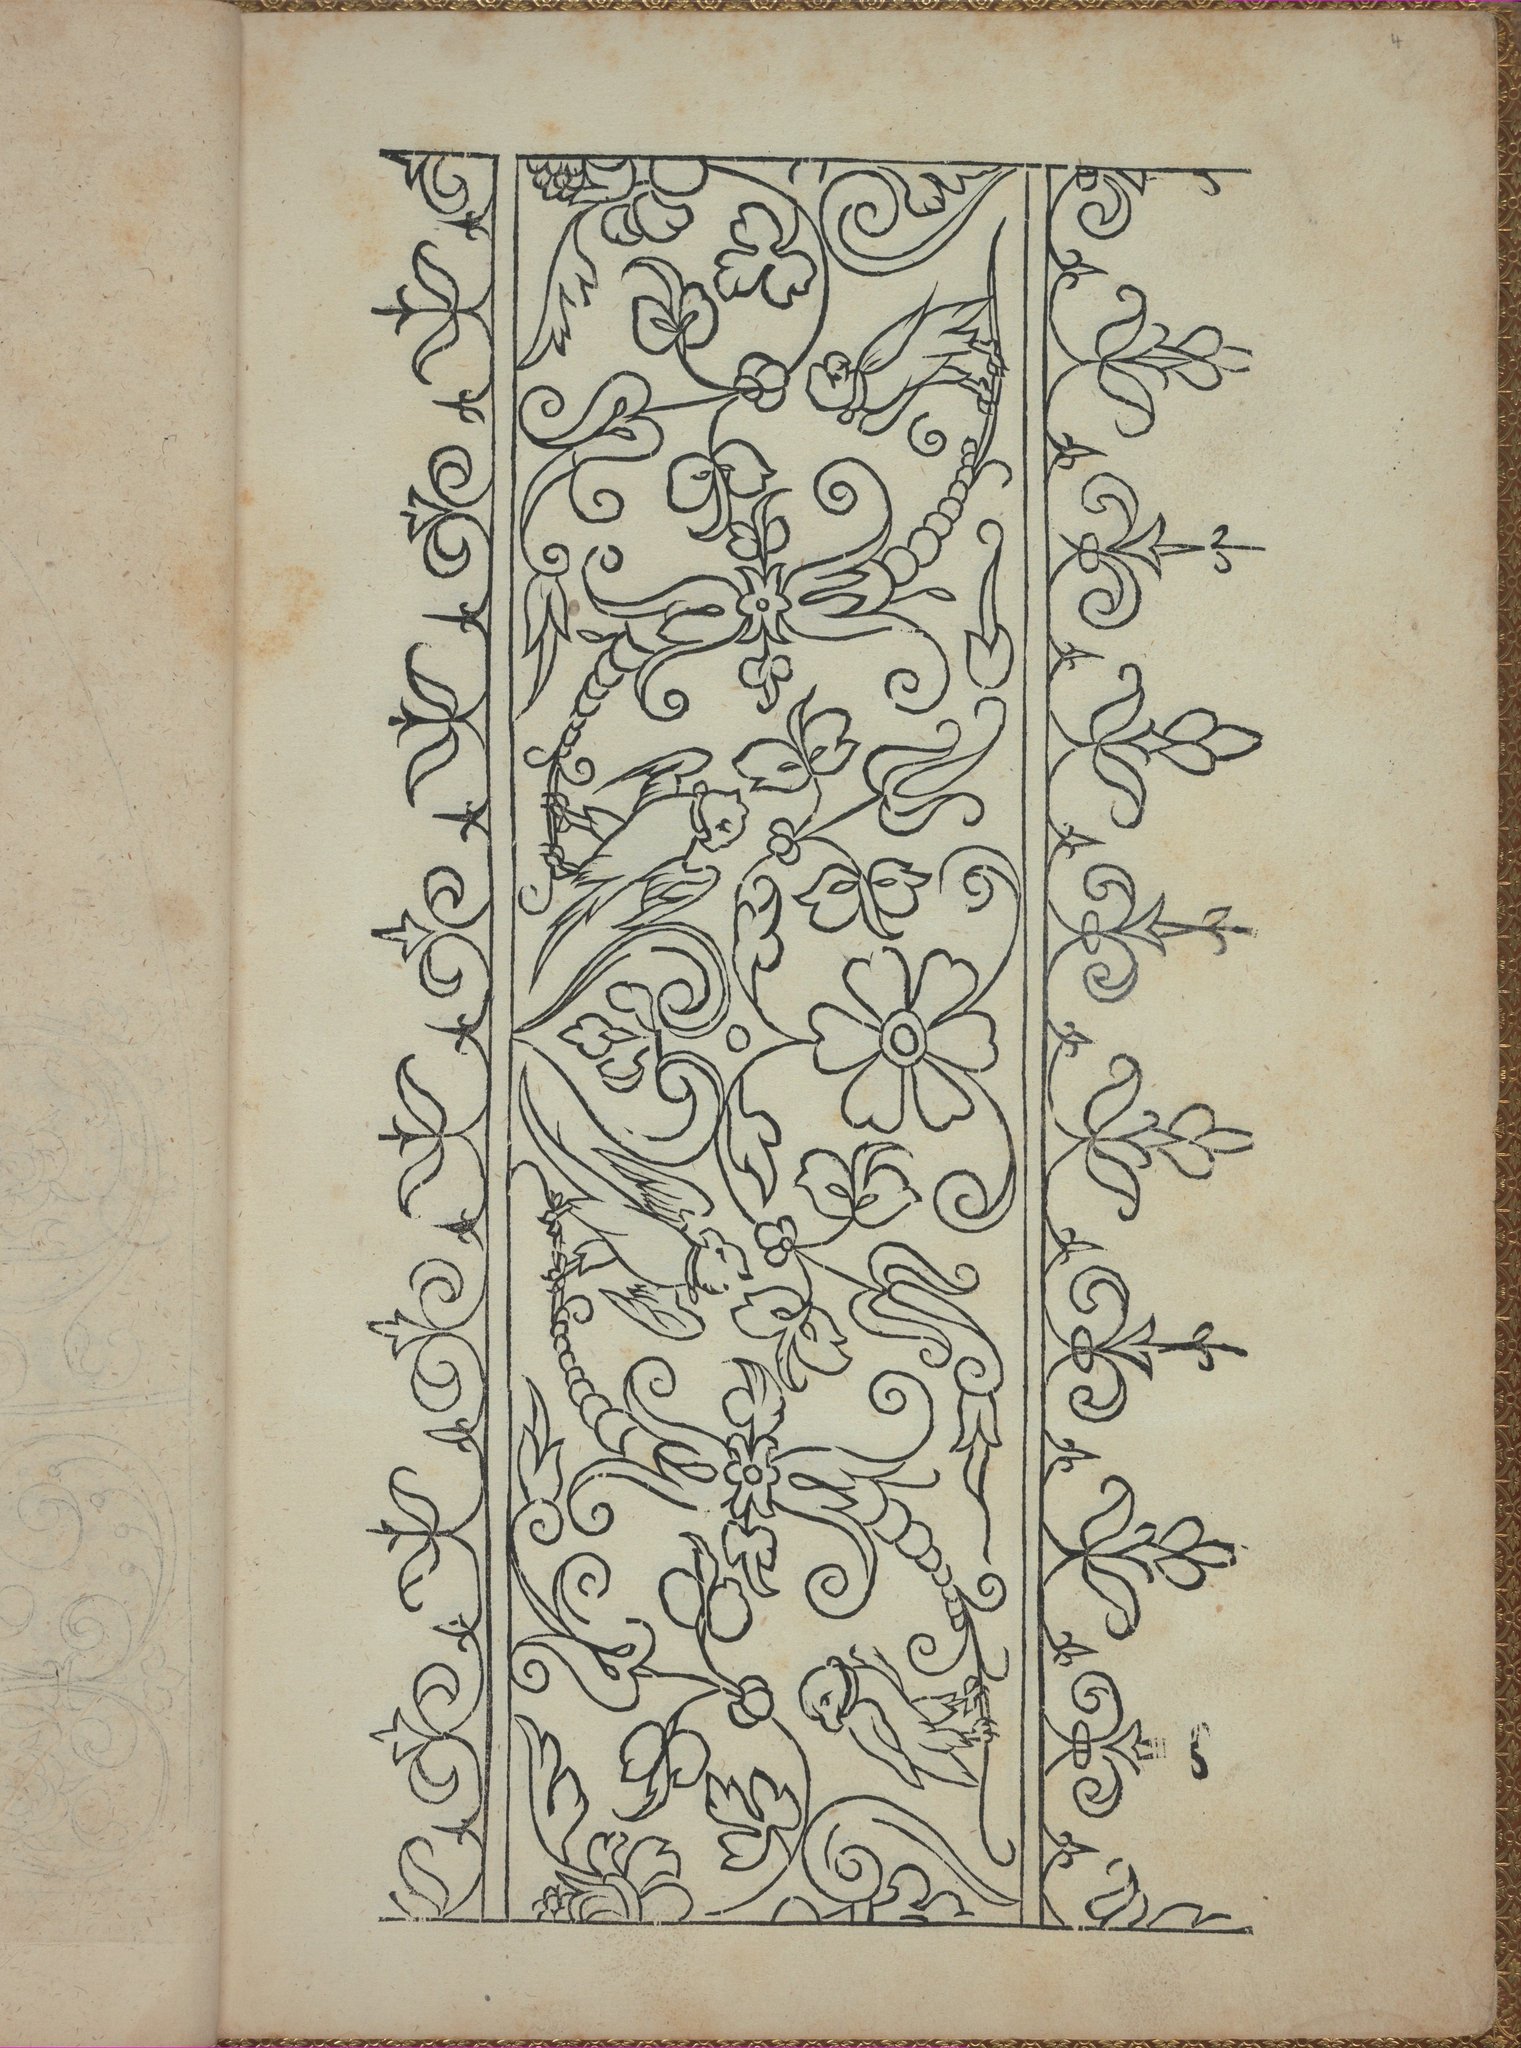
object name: book print ornament architecture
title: New Modelbüch (Page 4r)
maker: andreas bretschneider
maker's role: designer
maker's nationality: german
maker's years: 1573-1645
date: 1615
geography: germany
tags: flowers